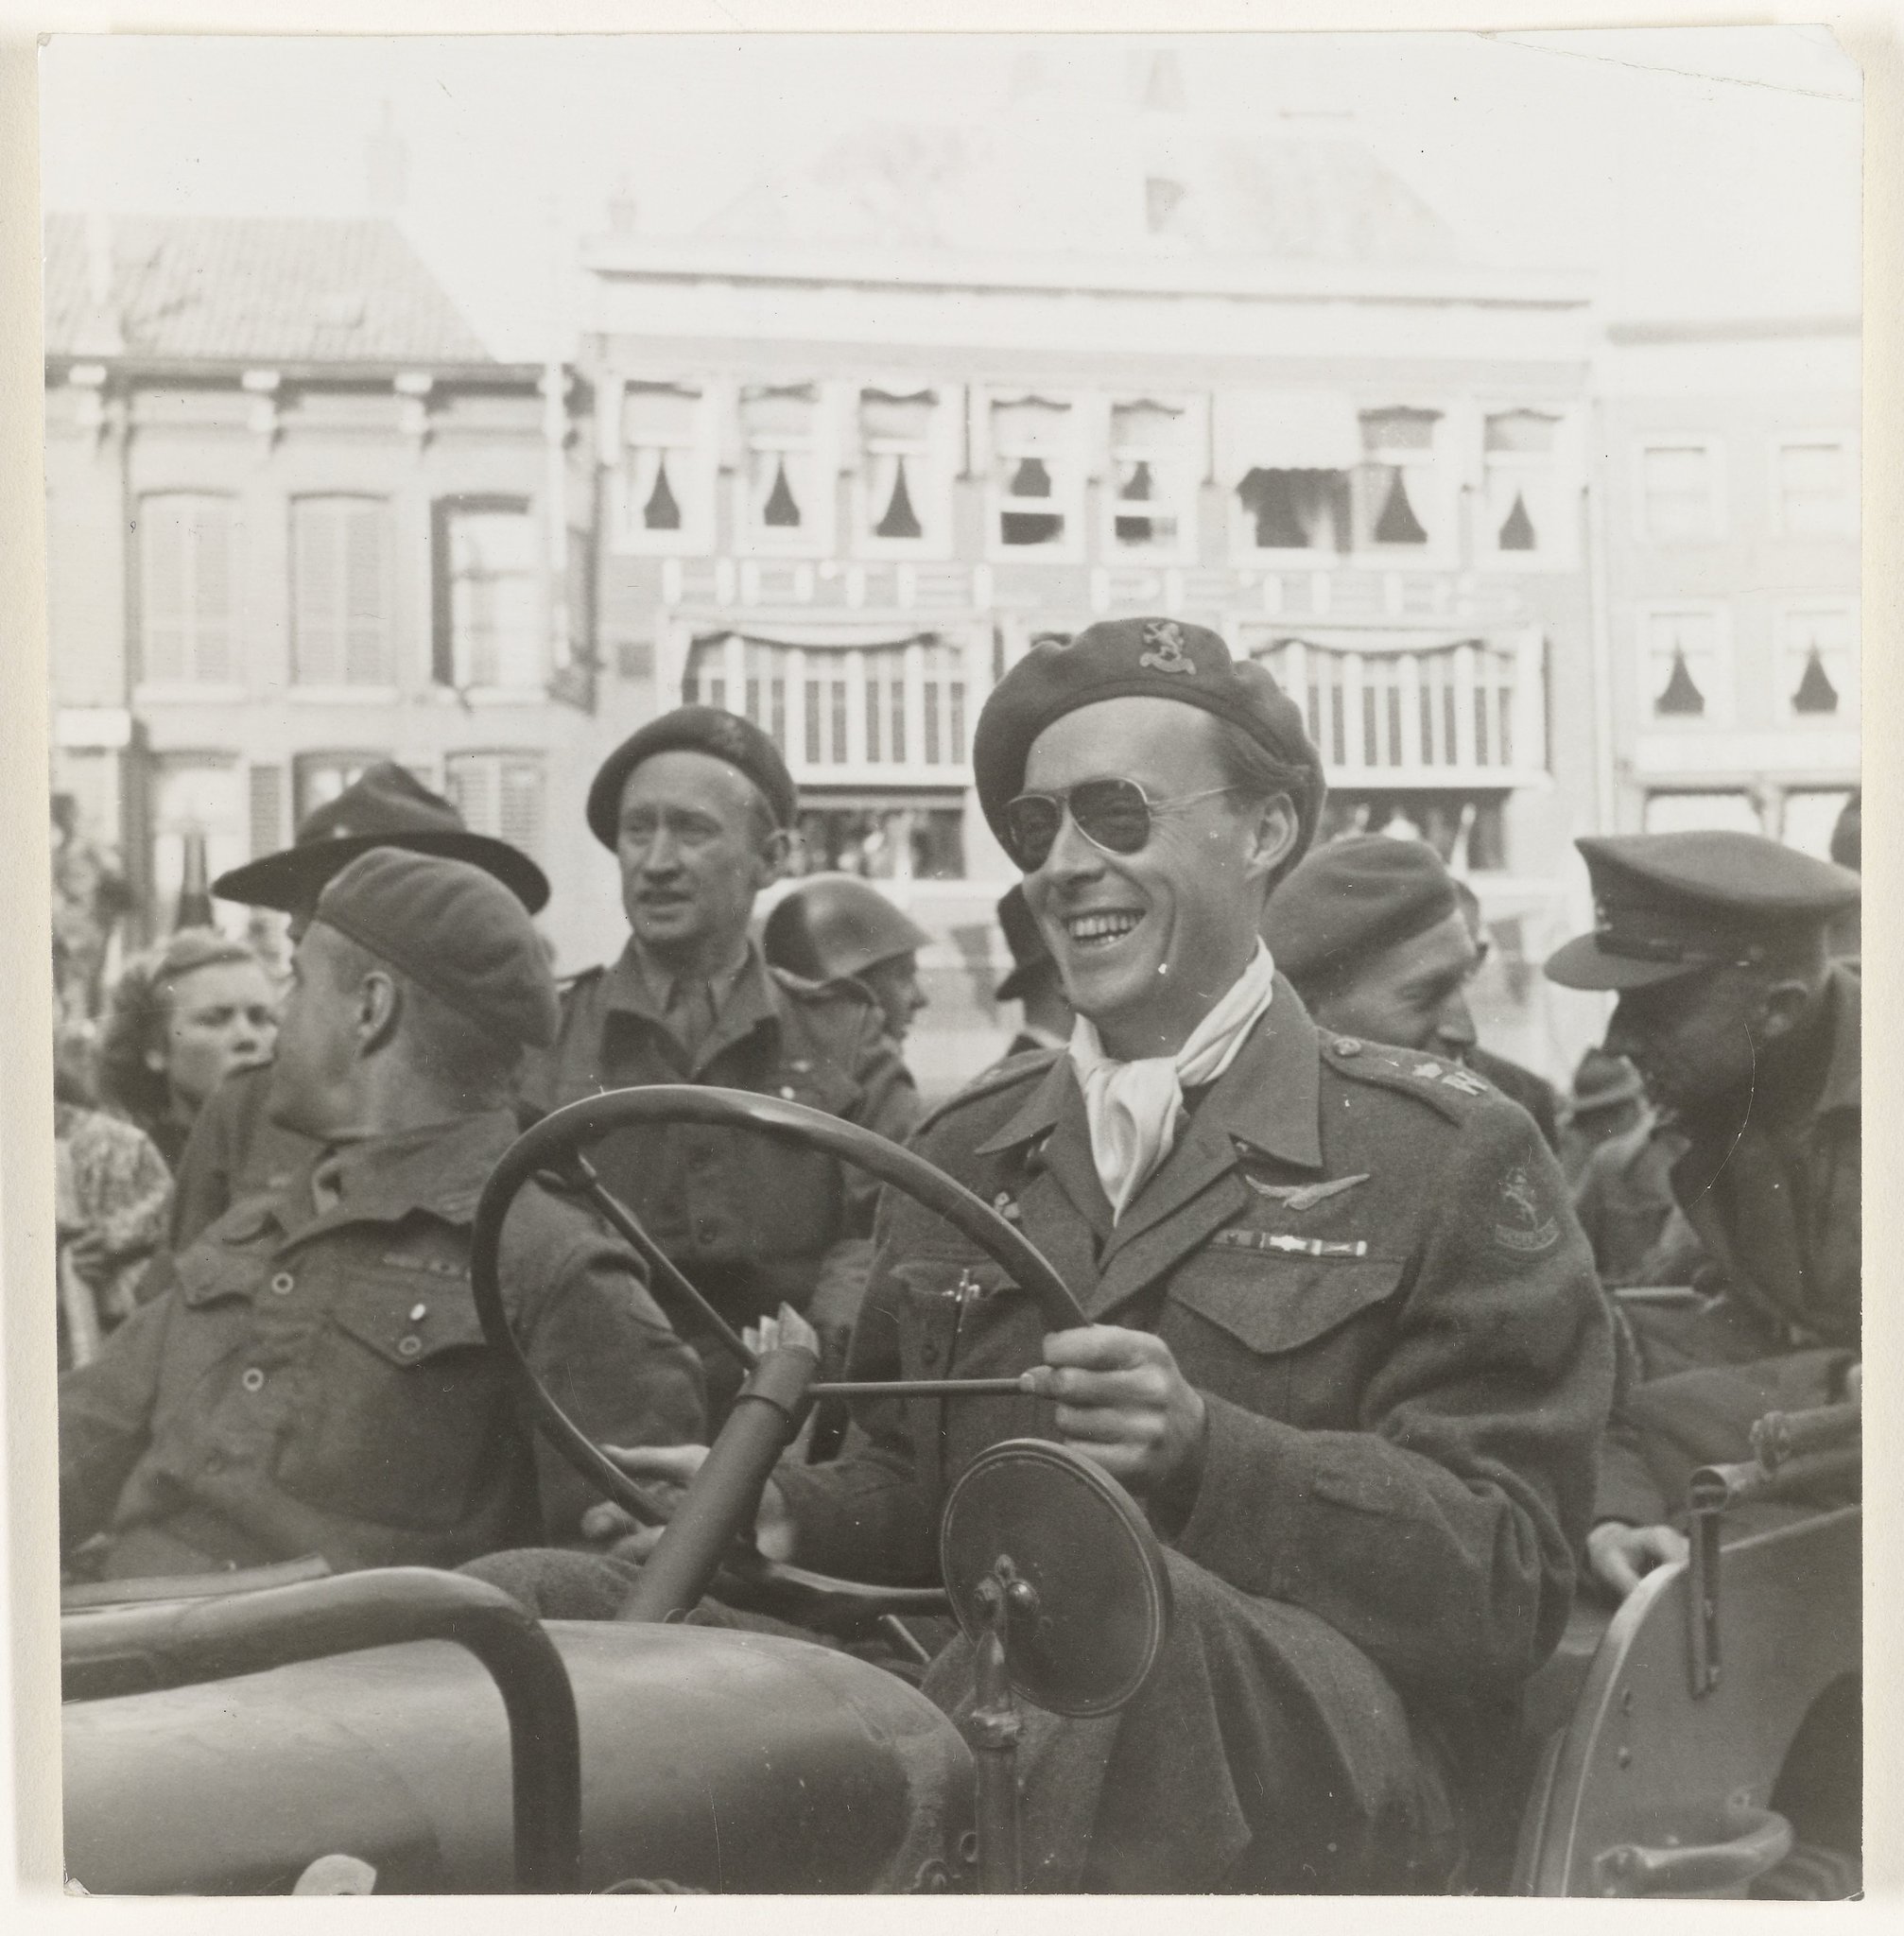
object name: photograph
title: Prins Bernhard in een jeep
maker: willem van der pol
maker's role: fotograaf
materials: photographic support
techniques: photography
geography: netherlands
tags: utrecht, bernhard (prins der nederlanden), netherlands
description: Prins Bernhard ging meteen na de bevrijding van Noord-Oost Nederland op bezoek in diverse steden. [Baruch, Jet, 2006].